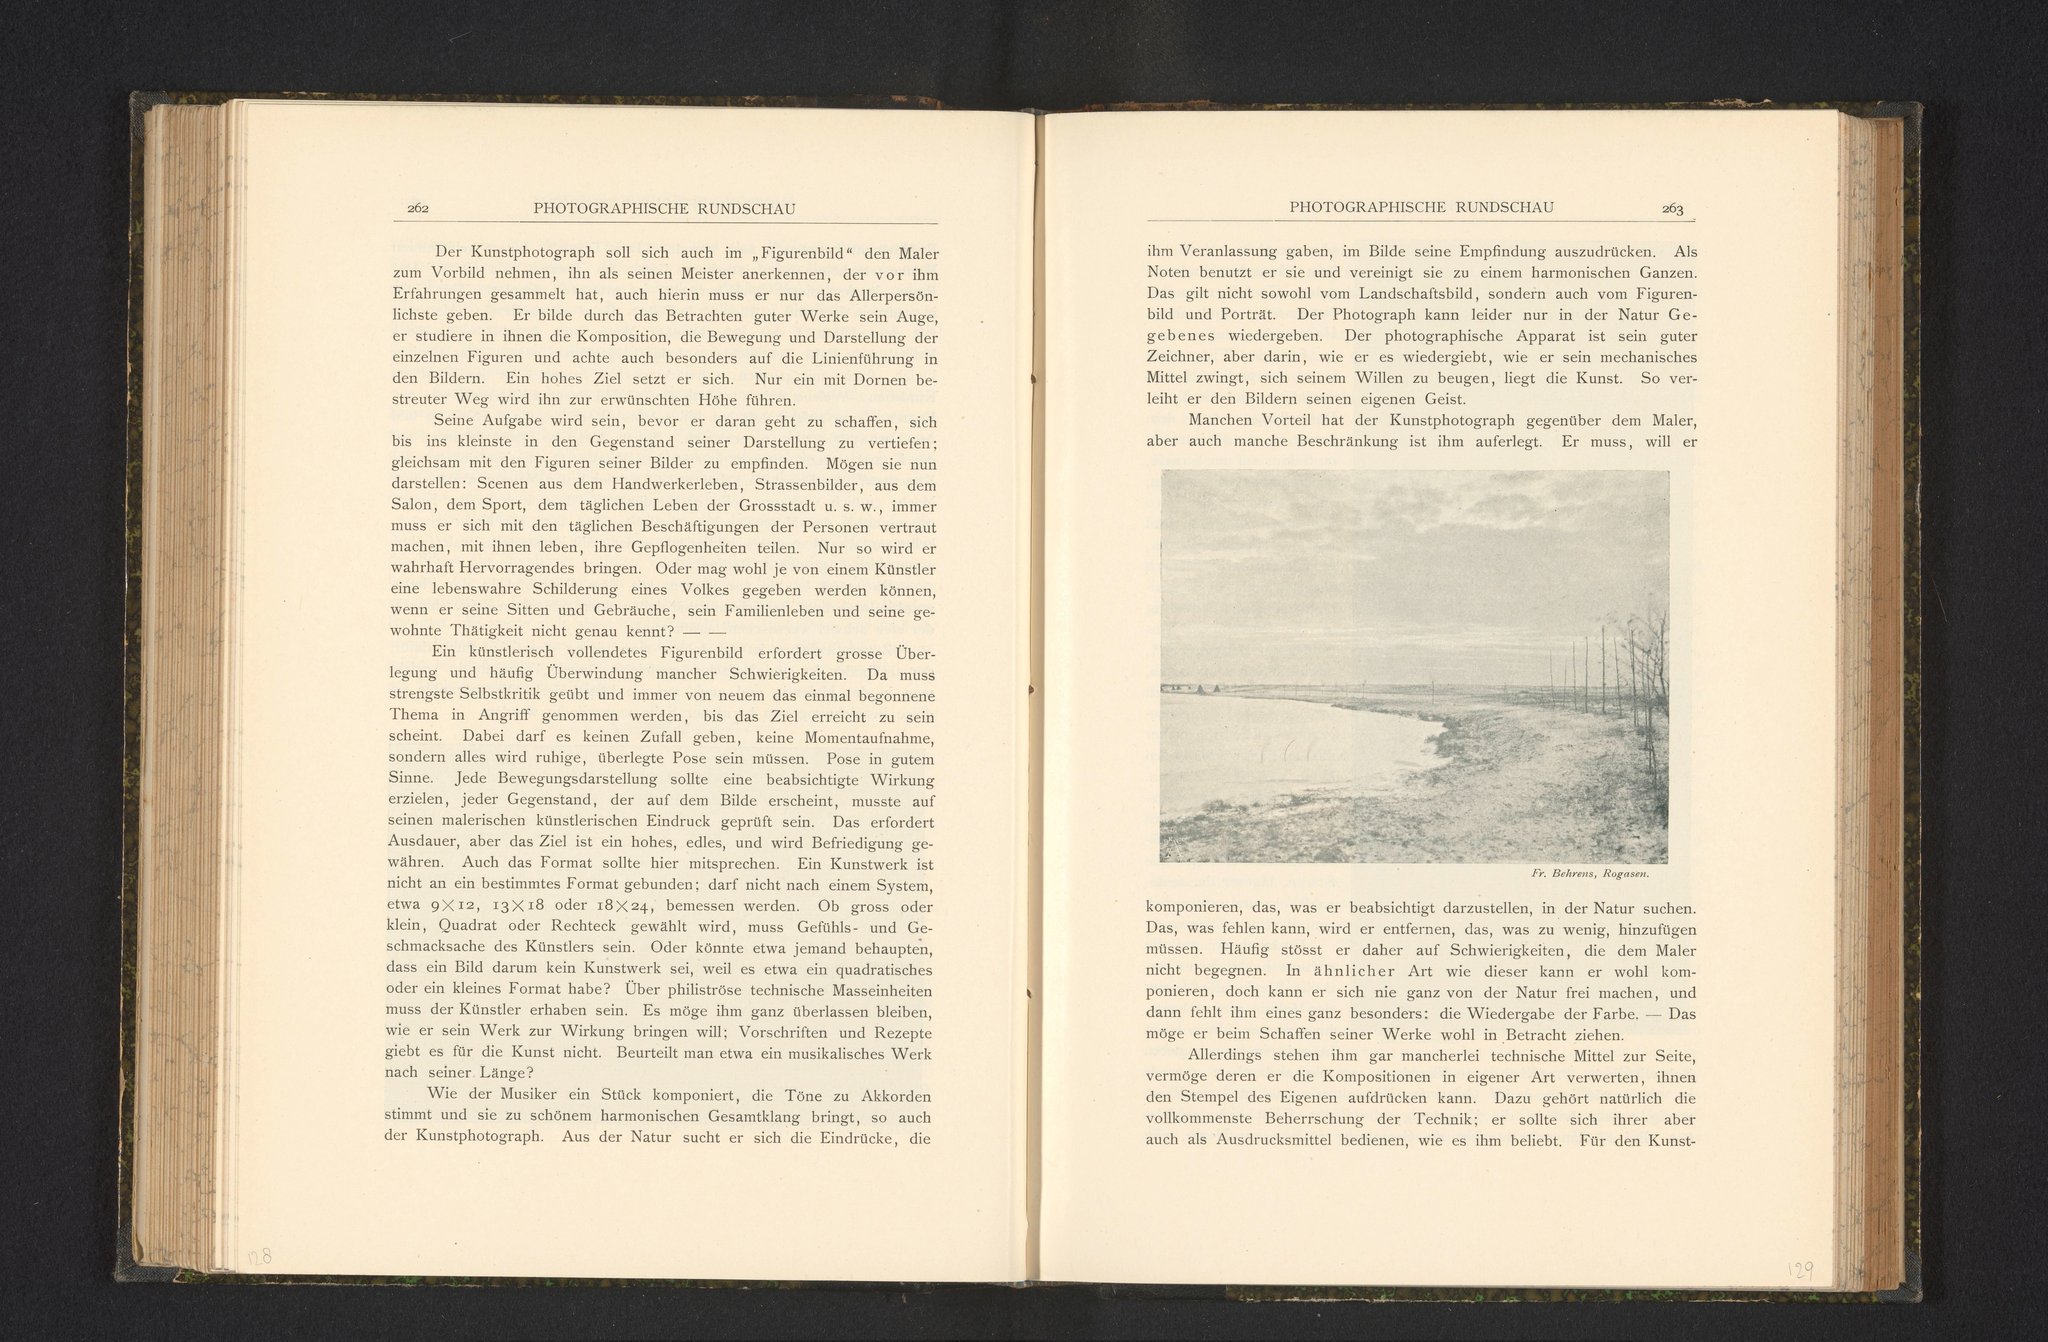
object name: photomechanical print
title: Gezicht op een water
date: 1893-1898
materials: paper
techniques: autotype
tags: landscapes with waters, waterscapes, seascapes (in the temperate zone)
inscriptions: monogram: ‘drAco’